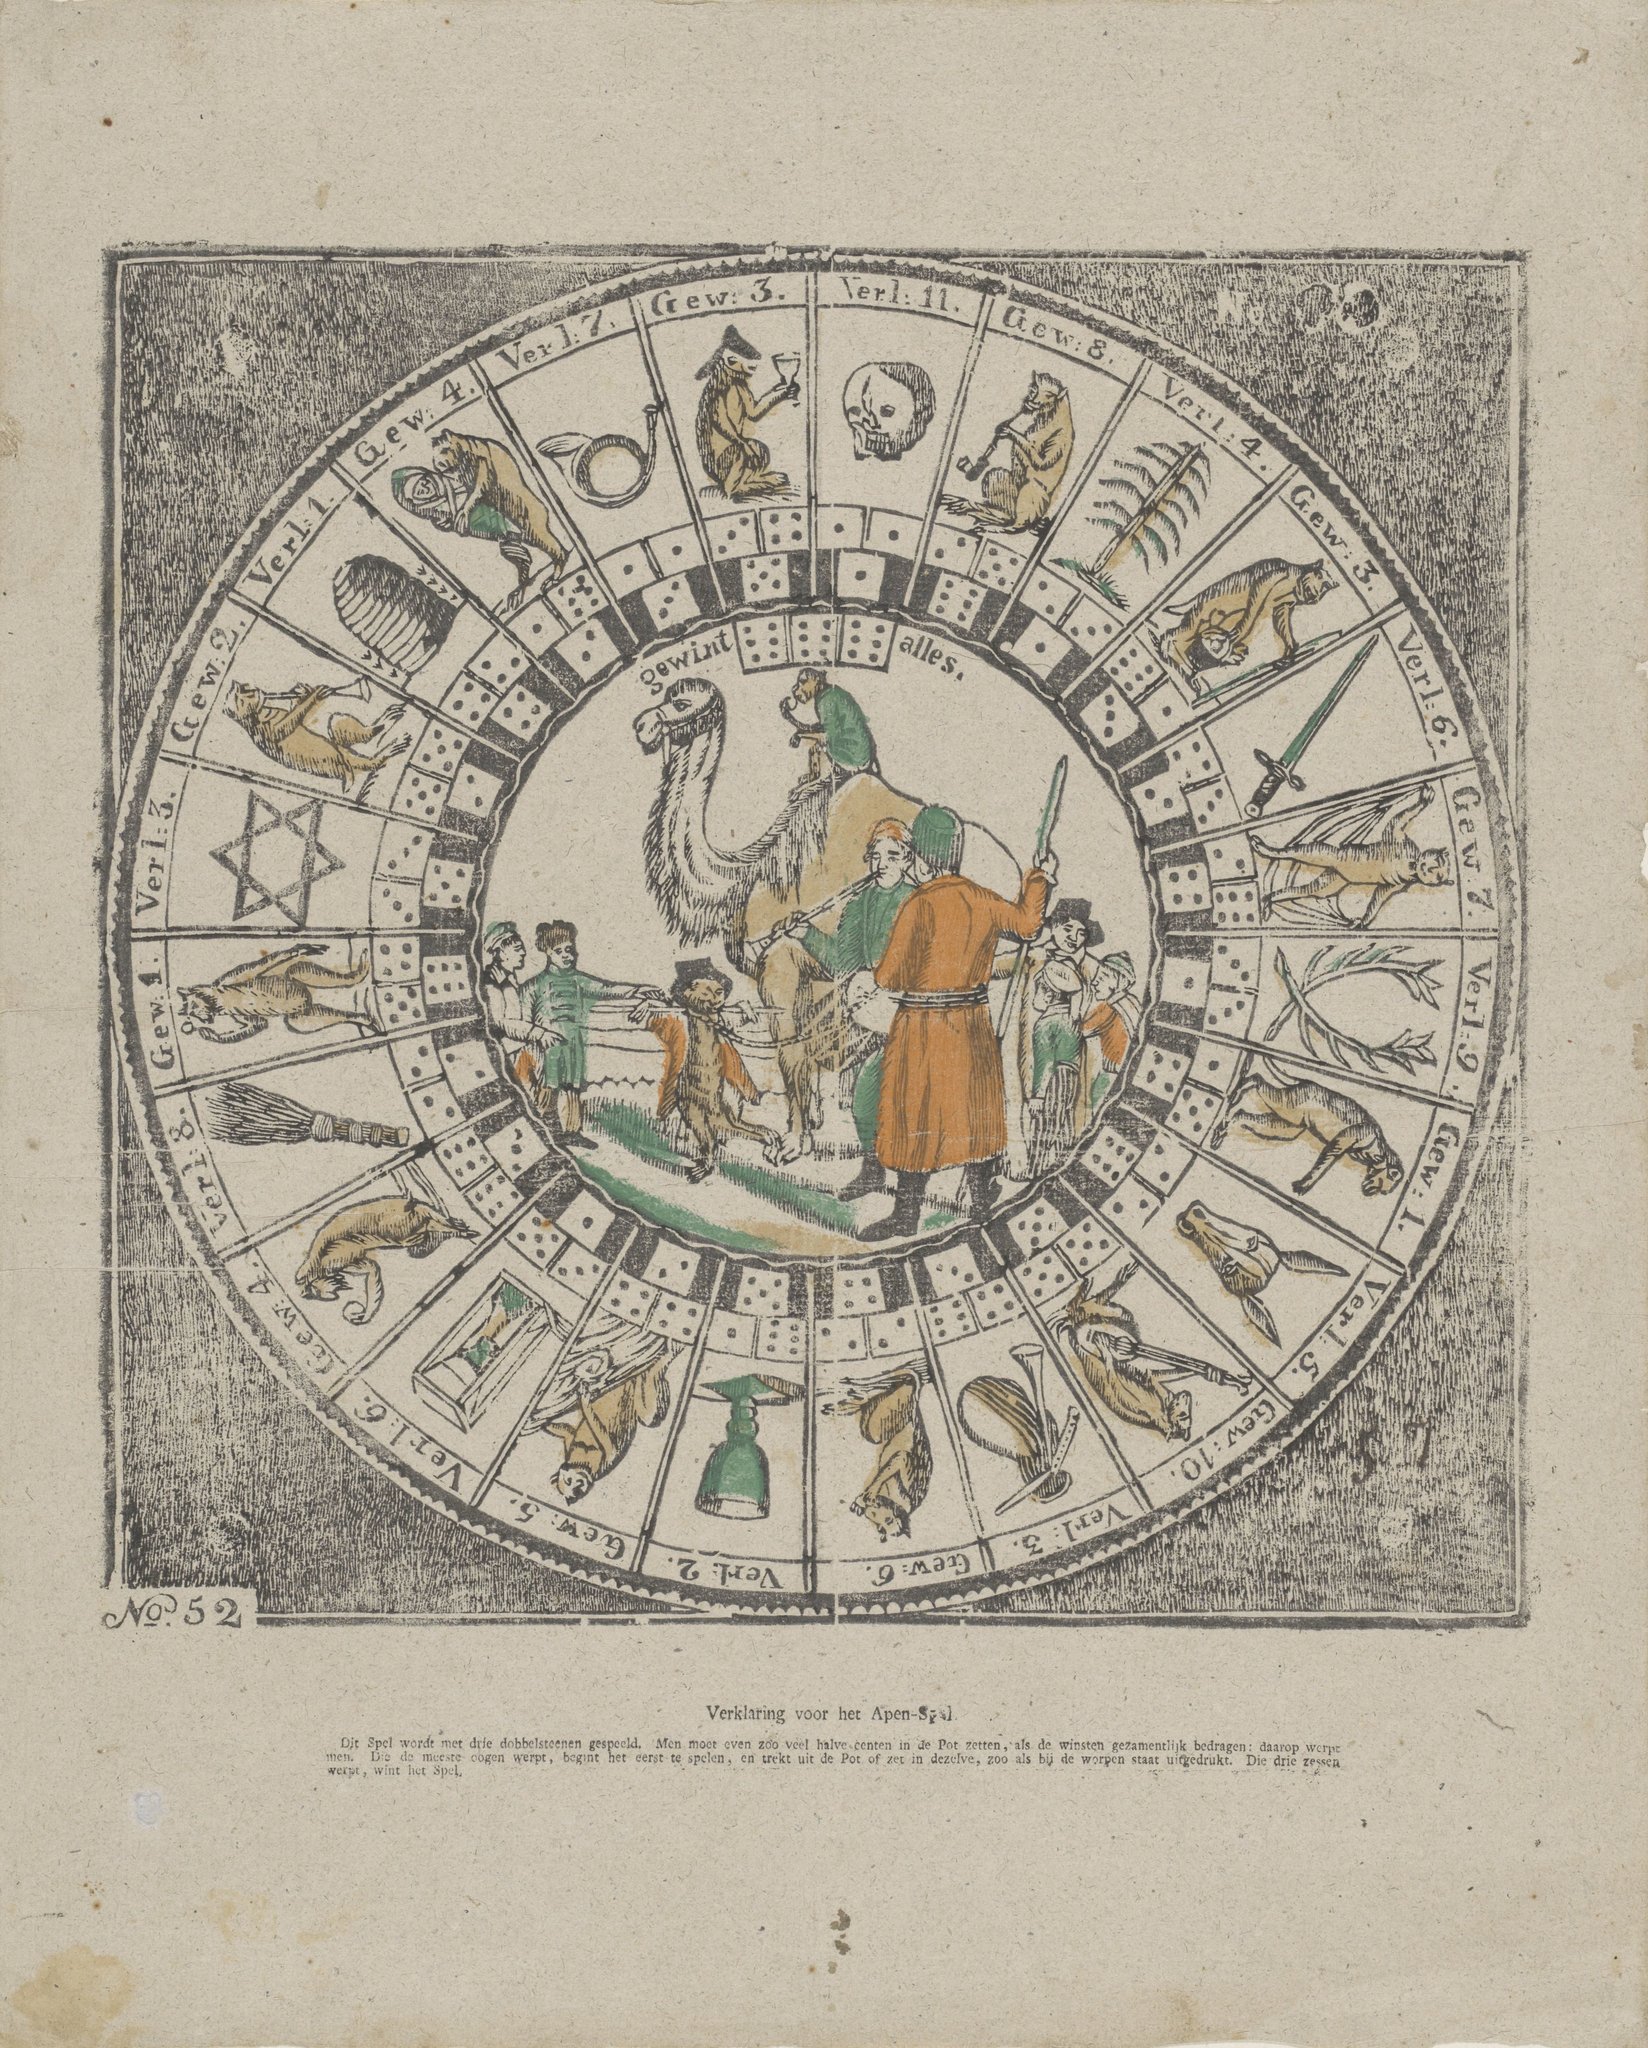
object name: popular print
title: Apenspel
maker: Anonymous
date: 1700-1899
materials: paper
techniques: colour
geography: netherlands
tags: board-games of chance, monkeys, apes, board-games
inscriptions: collector's mark: Lugt 2760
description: Cirkelvormig bordspel met voorstellingen van apen en voorwerpen in de vakjes. In het midden een voorstelling van mannen met een dromedaris en twee apen. Midden onder de spelregels in boekdruk. Genummerd linksonder: No. 52.